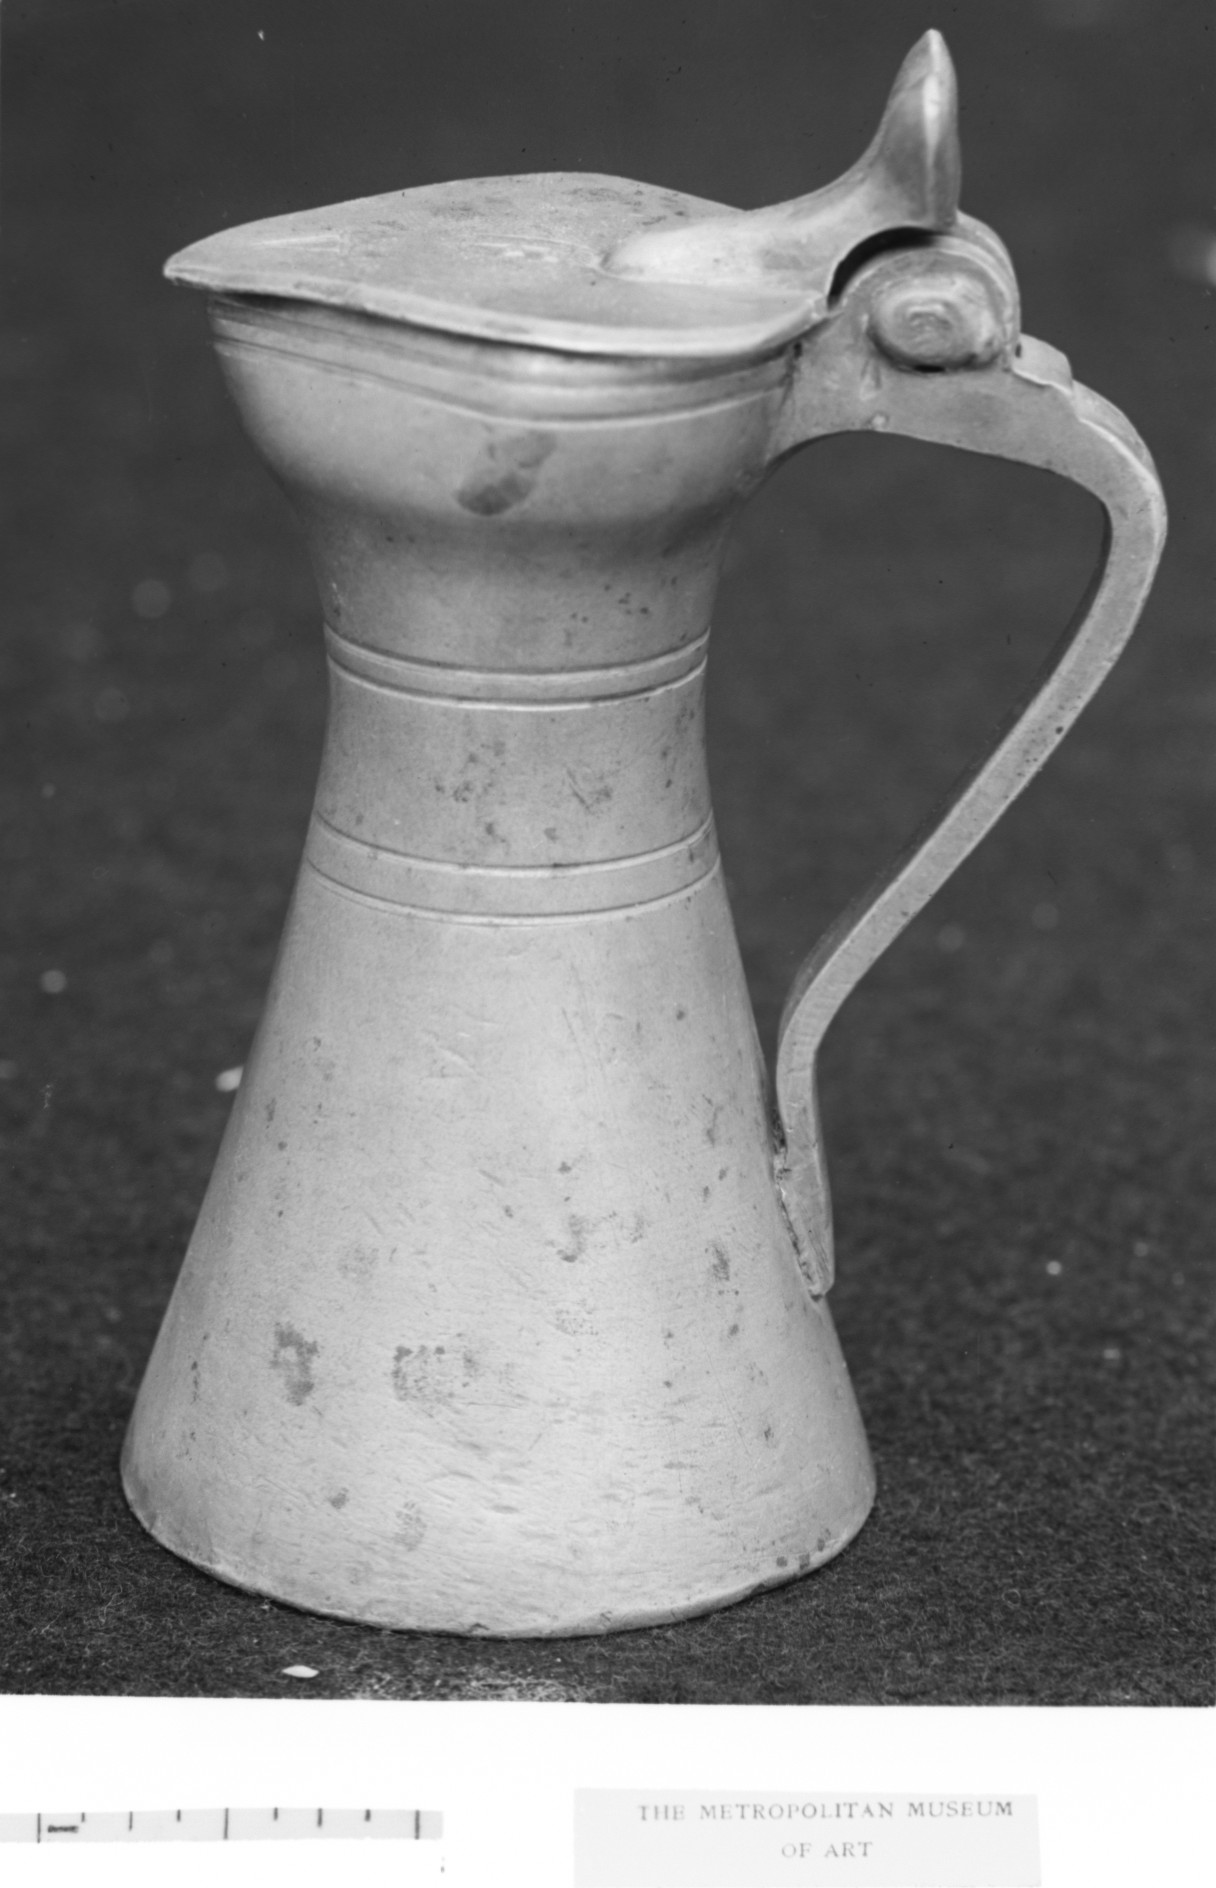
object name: measure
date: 1601-1700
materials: pewter